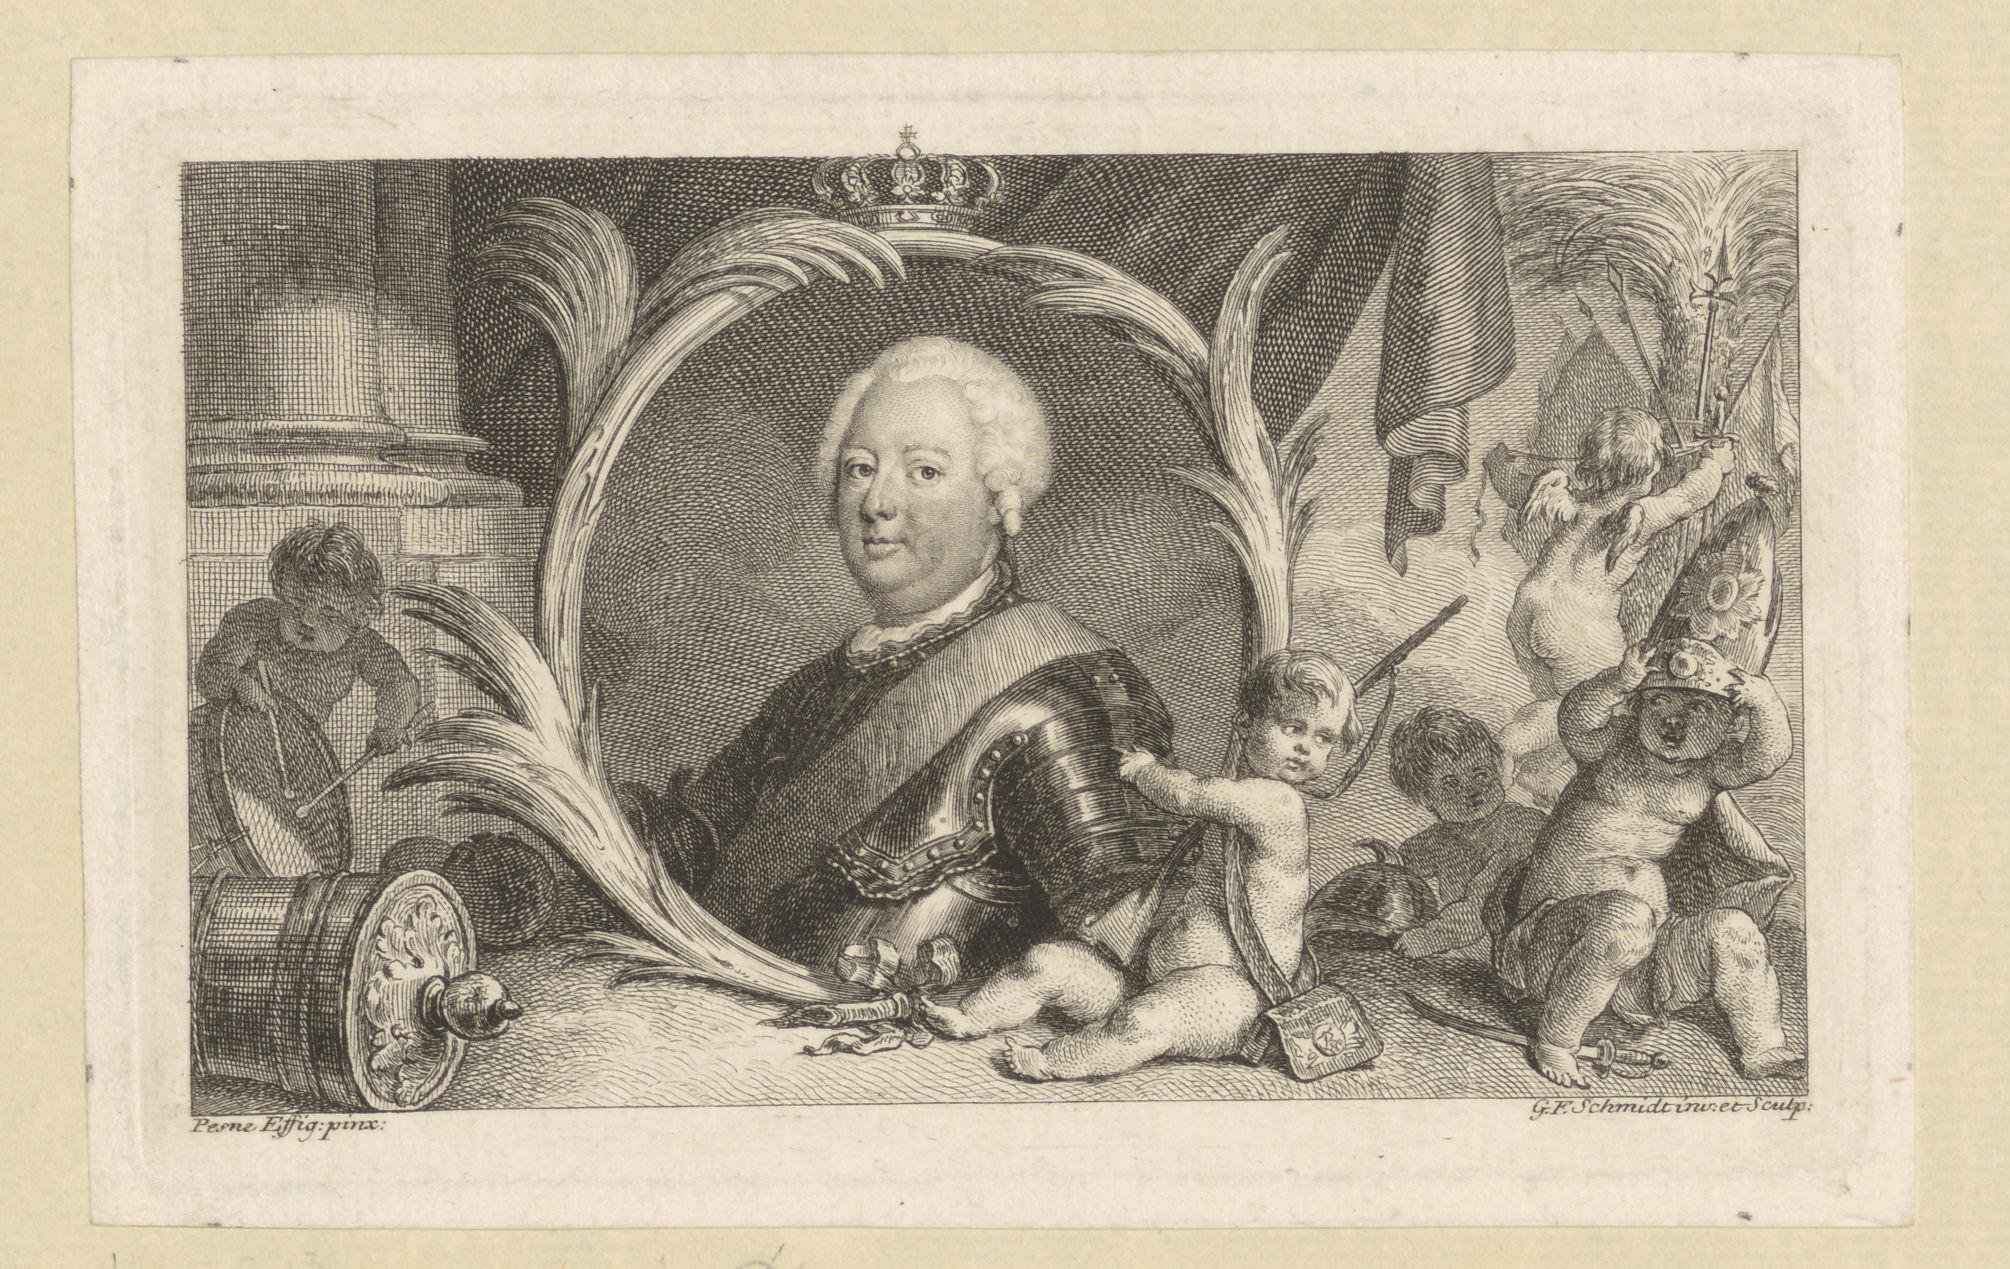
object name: print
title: Portret van Frederik Willem I, koning van Pruisen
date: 1751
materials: paper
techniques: engraving, etching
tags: berlin, frederik willem i koning van pruisen, historical persons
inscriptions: collector's mark: Lugt 240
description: Prent ook gebruikt in: Frederik de Grote. Mémoires pour servir a l'histoire de la maison de Brandebourg. Sanssouci, Frederik de Grote, 1751.